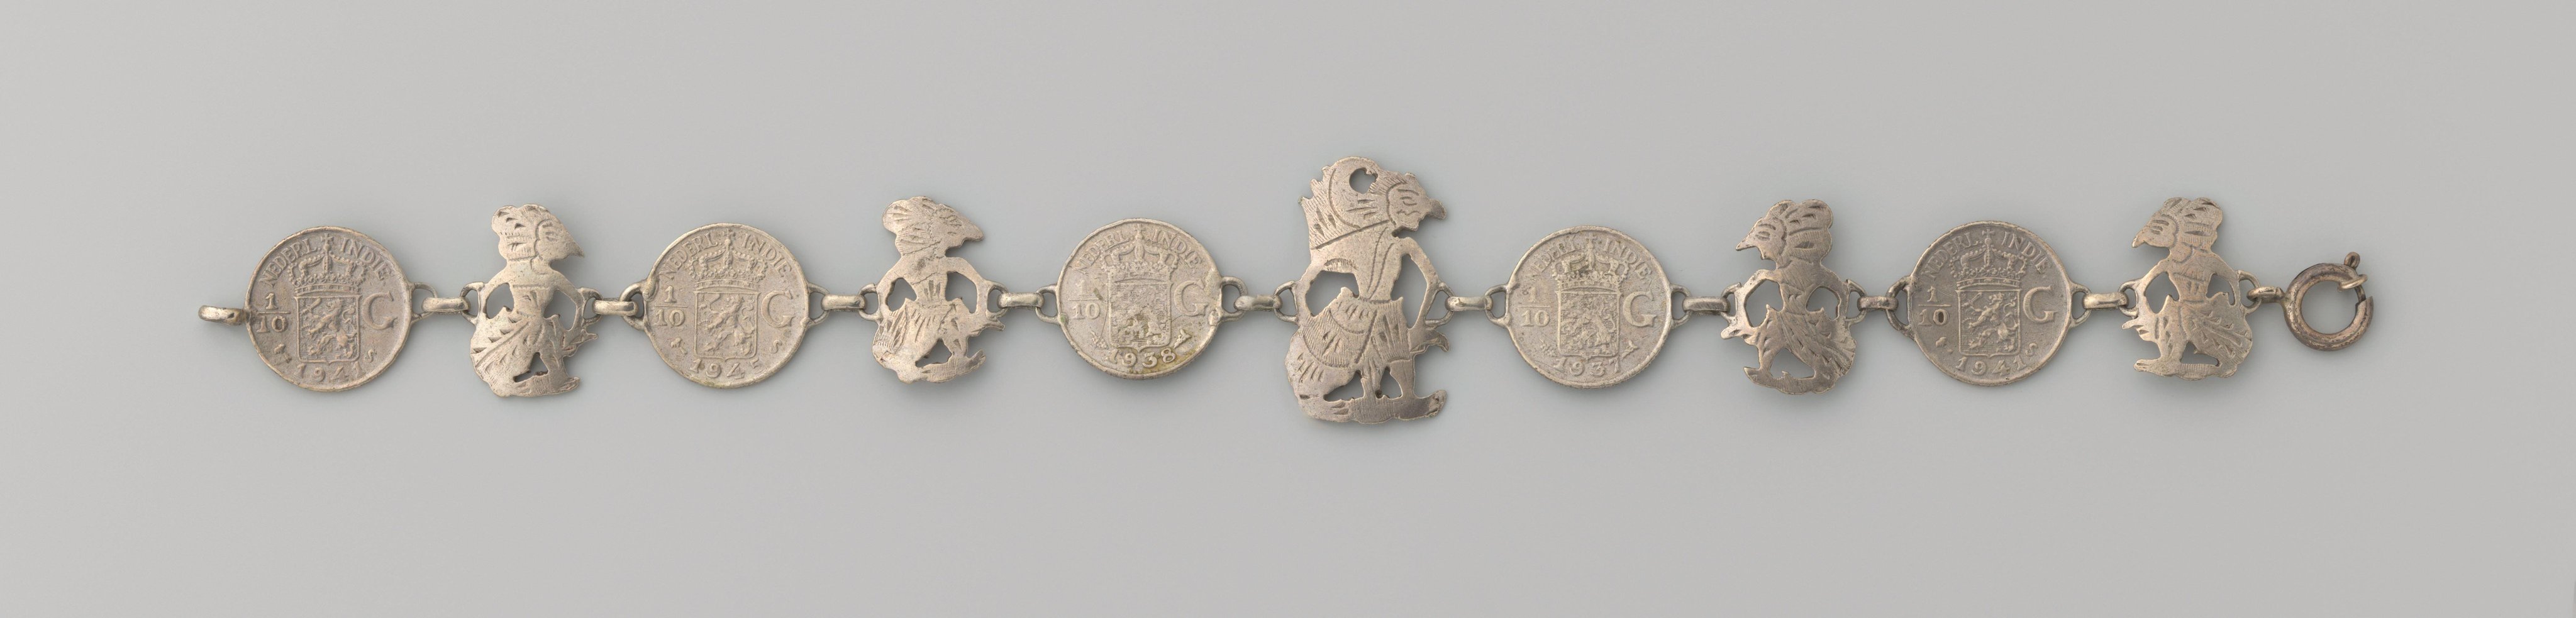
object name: bracelet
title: Armband van zilver met vijf dubbeltjes en vijf wajangpoppen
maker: Anonymous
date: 1940-1950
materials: silver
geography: netherlands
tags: dutch east indies, the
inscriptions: wajangschakel: Om zo 800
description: Armband van zilver met vijf Nederlands-Indische dubbeltjes en vijf wajangpoppen voorzien van een veerring. De dubbeltjes en de poppen zijn om en om met eenvoudige ringen aaneengeschakeld. Op één van de wajangschakels staat 'Om zo 800'.